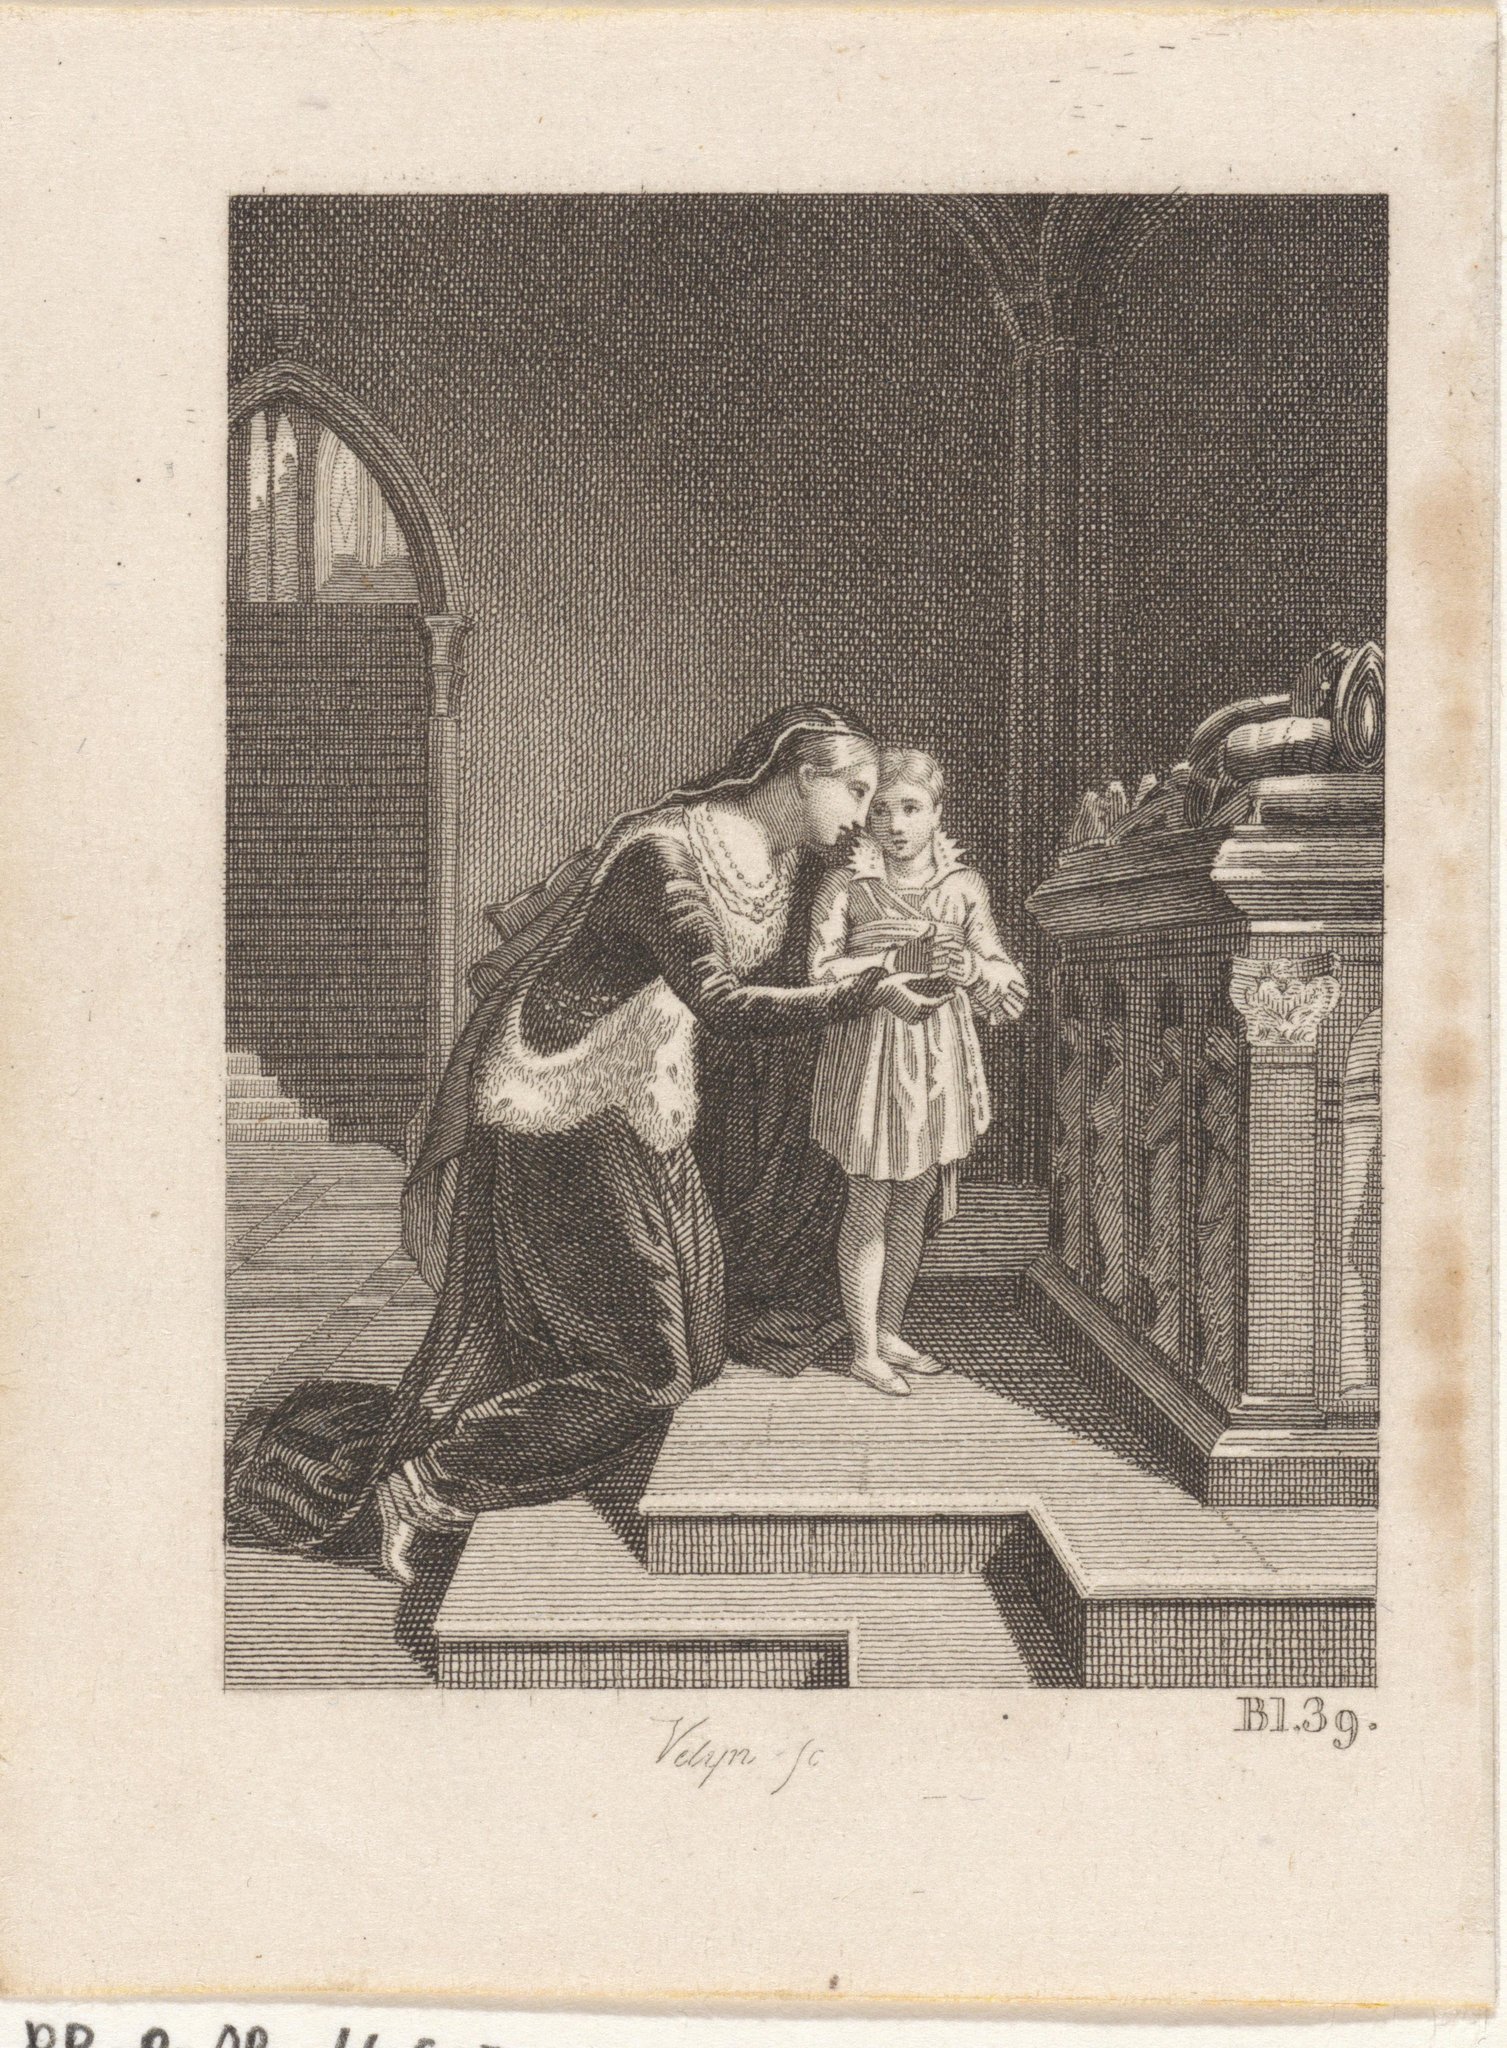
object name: print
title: Jeanne d'Albret met het kind Henry de Bourbon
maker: philippus velijn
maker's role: print maker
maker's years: 1787-1836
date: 1821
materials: paper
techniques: etching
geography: netherlands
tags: antoine de bourbon (koning van navarra), paris, mother and son(s) (family group), prince - bb - female ruler, grave, tomb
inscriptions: collector's mark: Lugt 2228, inscription: ‘Jeanne d'Albert’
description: Jeanne d'Albret met het kind Henry de Bourbon, bij de graftombe van haar echtgenoot Antoine de Bourbon, koning van Navarra. Rechtsonder: bl. 39.